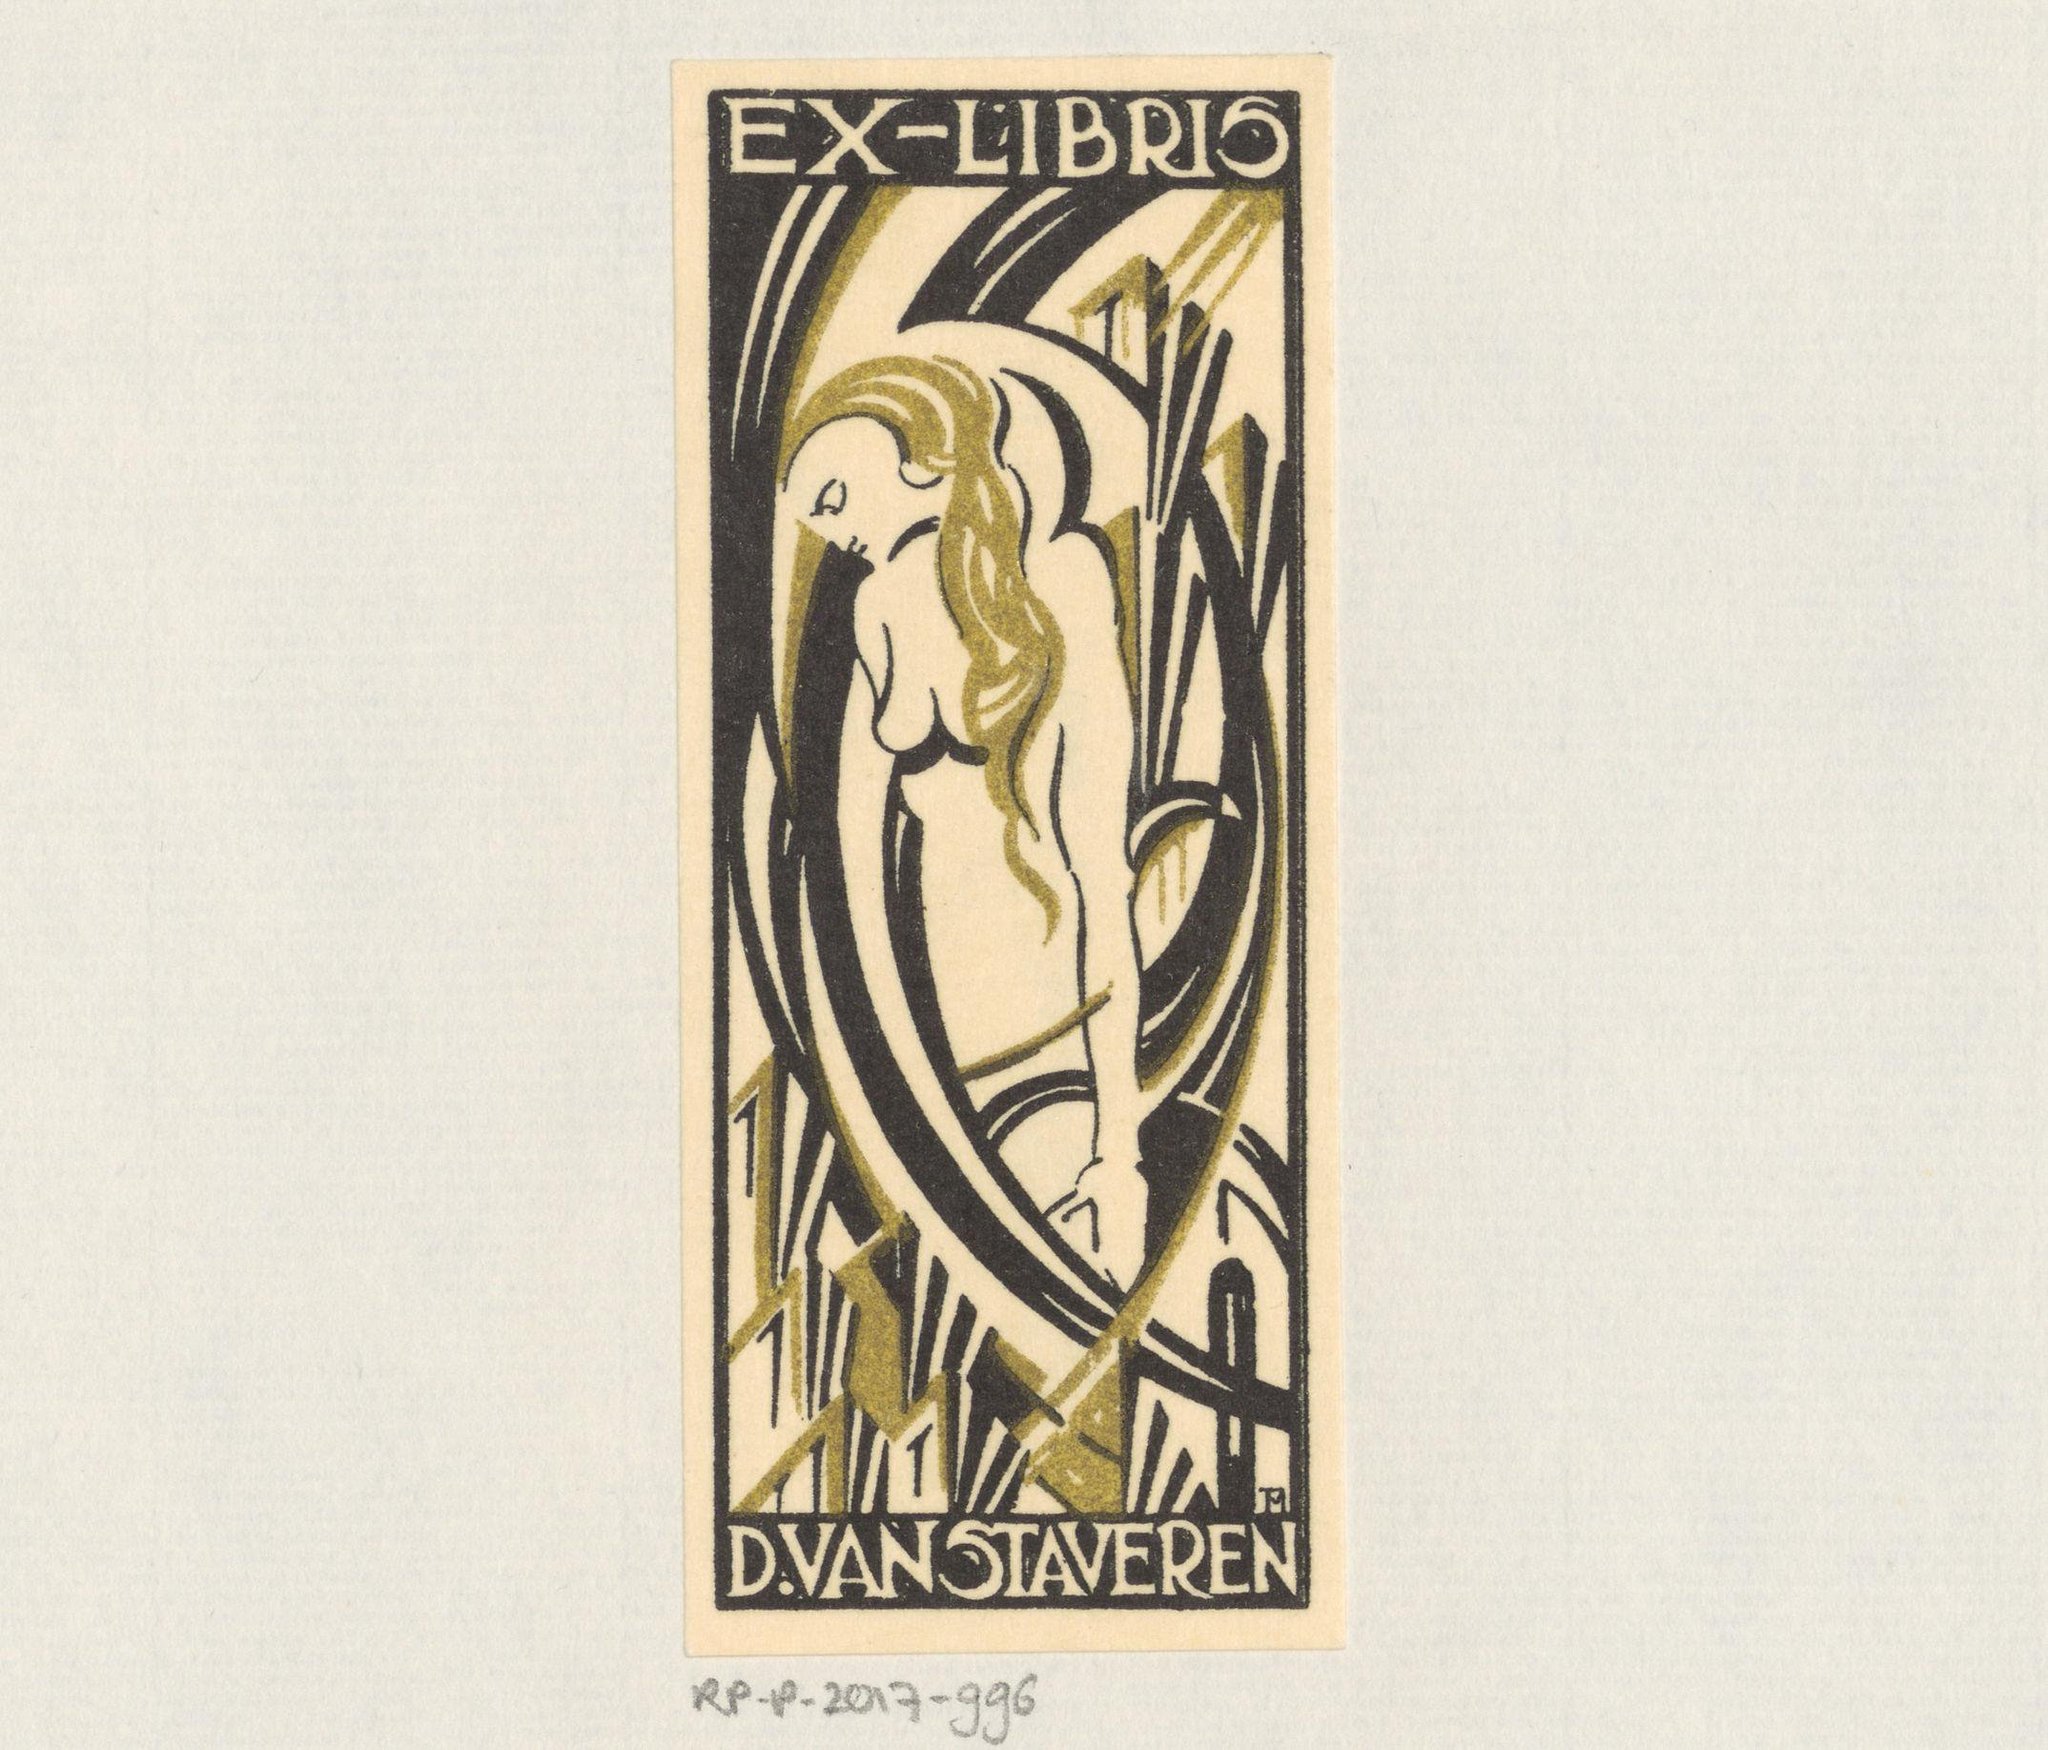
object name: bookplate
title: Ex libris van D. van Staveren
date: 1925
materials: paper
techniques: printing block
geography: netherlands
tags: utrecht, woman (showing herself) undressed, quasi-nude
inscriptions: signature, date and inscription: ‘van Staveren / M. van Dam del. 1925’